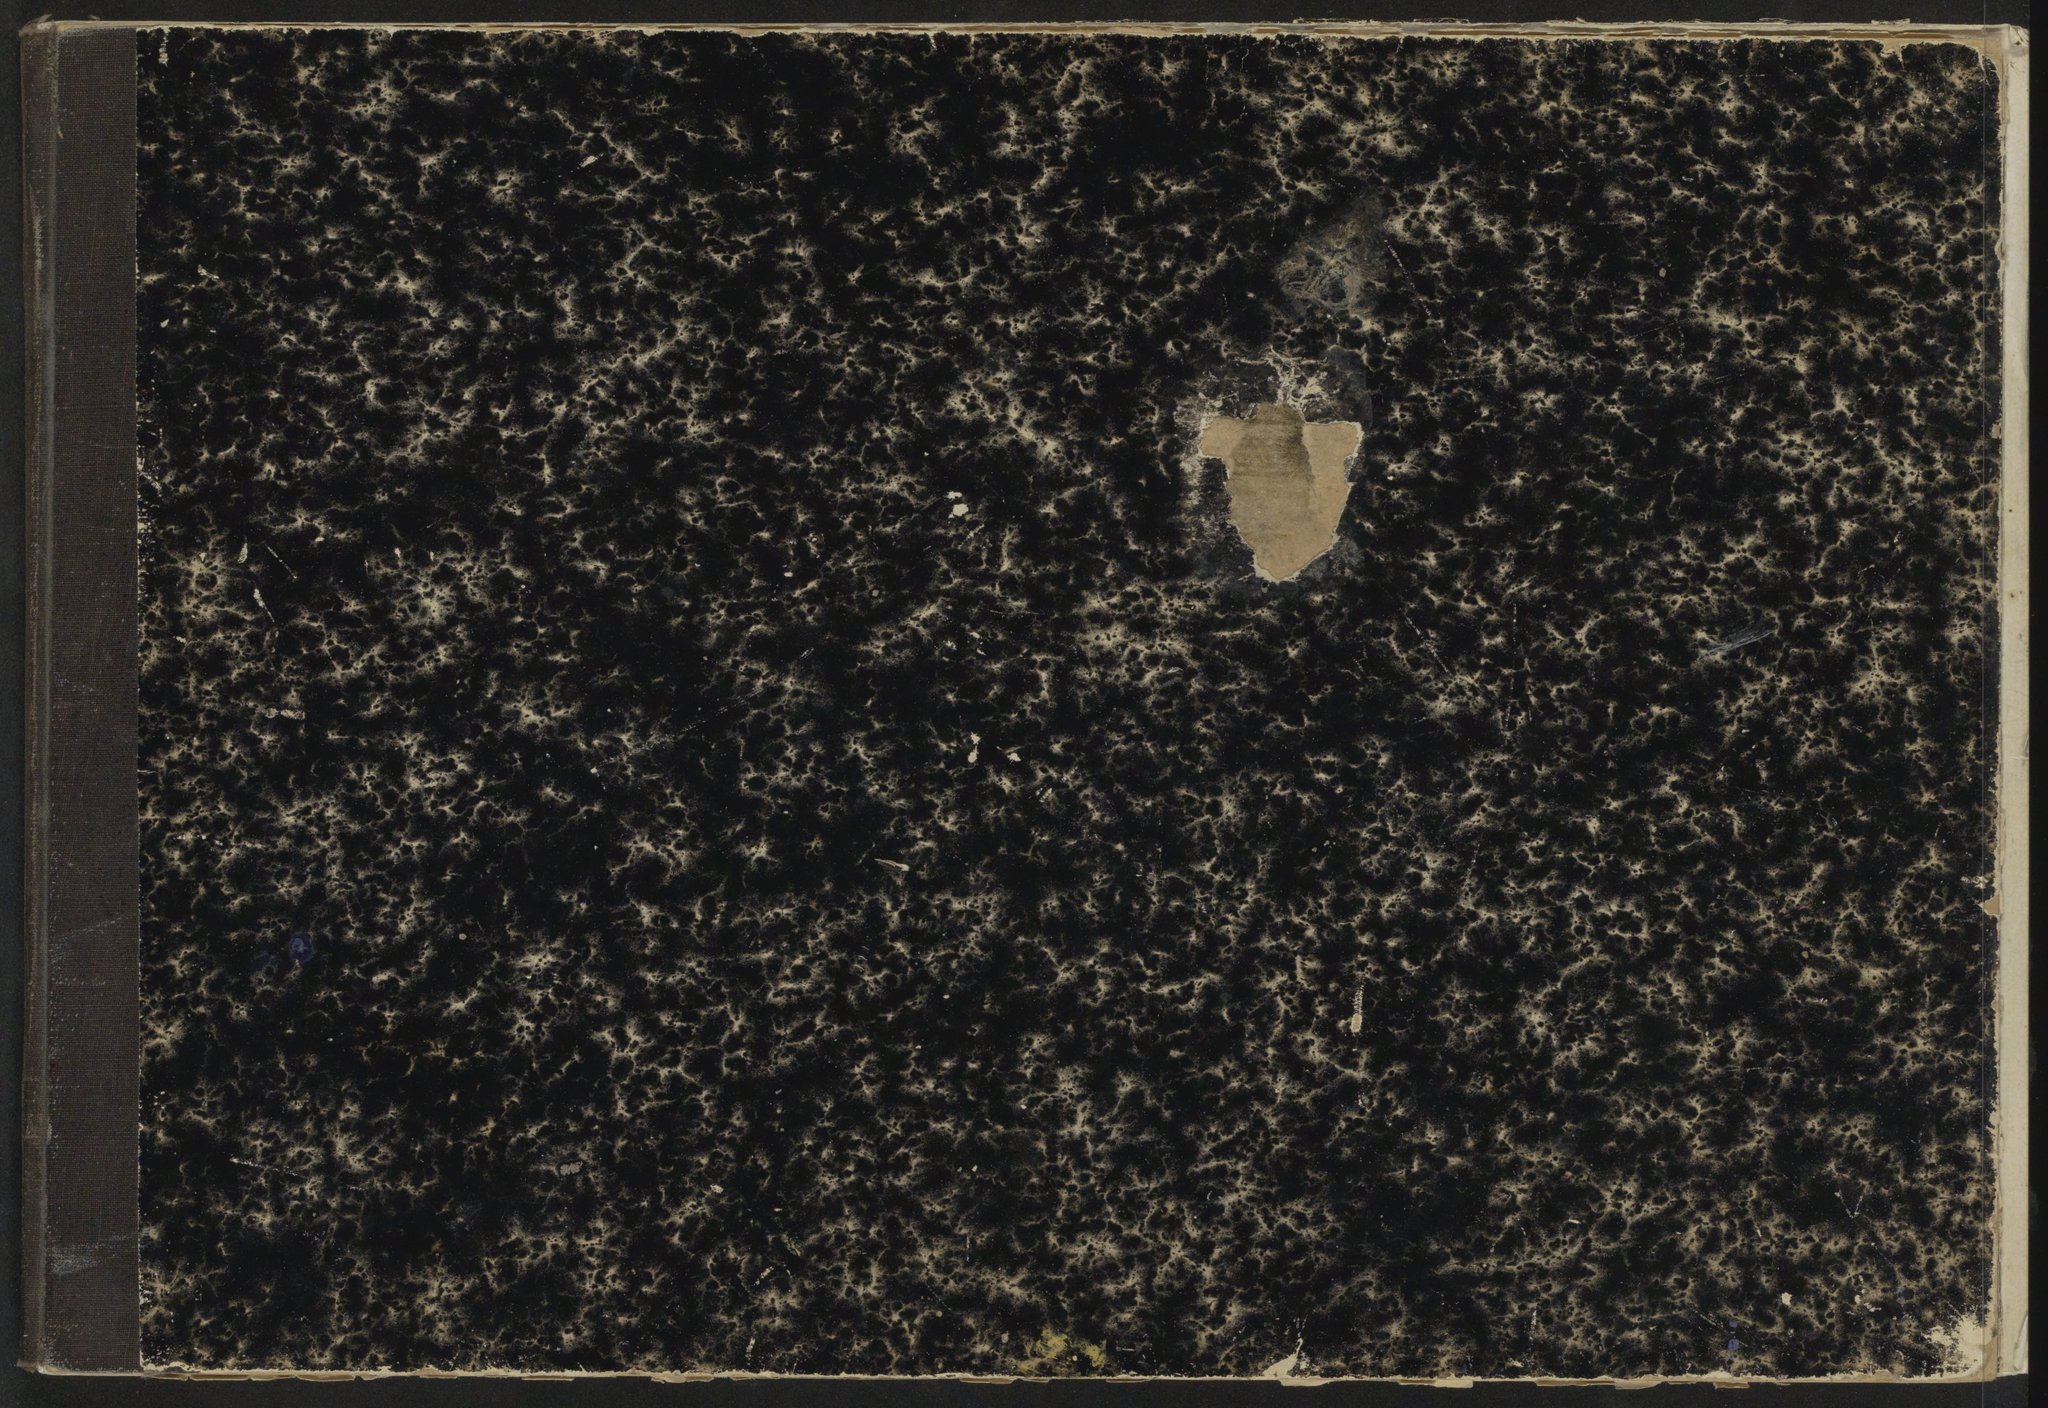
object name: sketchbook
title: Schetsboek met 17 bladen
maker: willem witsen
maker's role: draughtsman, painter, print maker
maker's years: 1860-1923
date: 1887-1892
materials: cardboard, chalk, linen, paper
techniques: marbling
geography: amsterdam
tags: undressing oneself, getting undressed - aa - female human figure, anonymous historical person portrayed alone, the (nude) human figure; 'corpo humano' (ripa) - aa - female human figure, amsterdam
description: Schetsboek bestaande uit 17 bladen met figuurstudies en portretten.